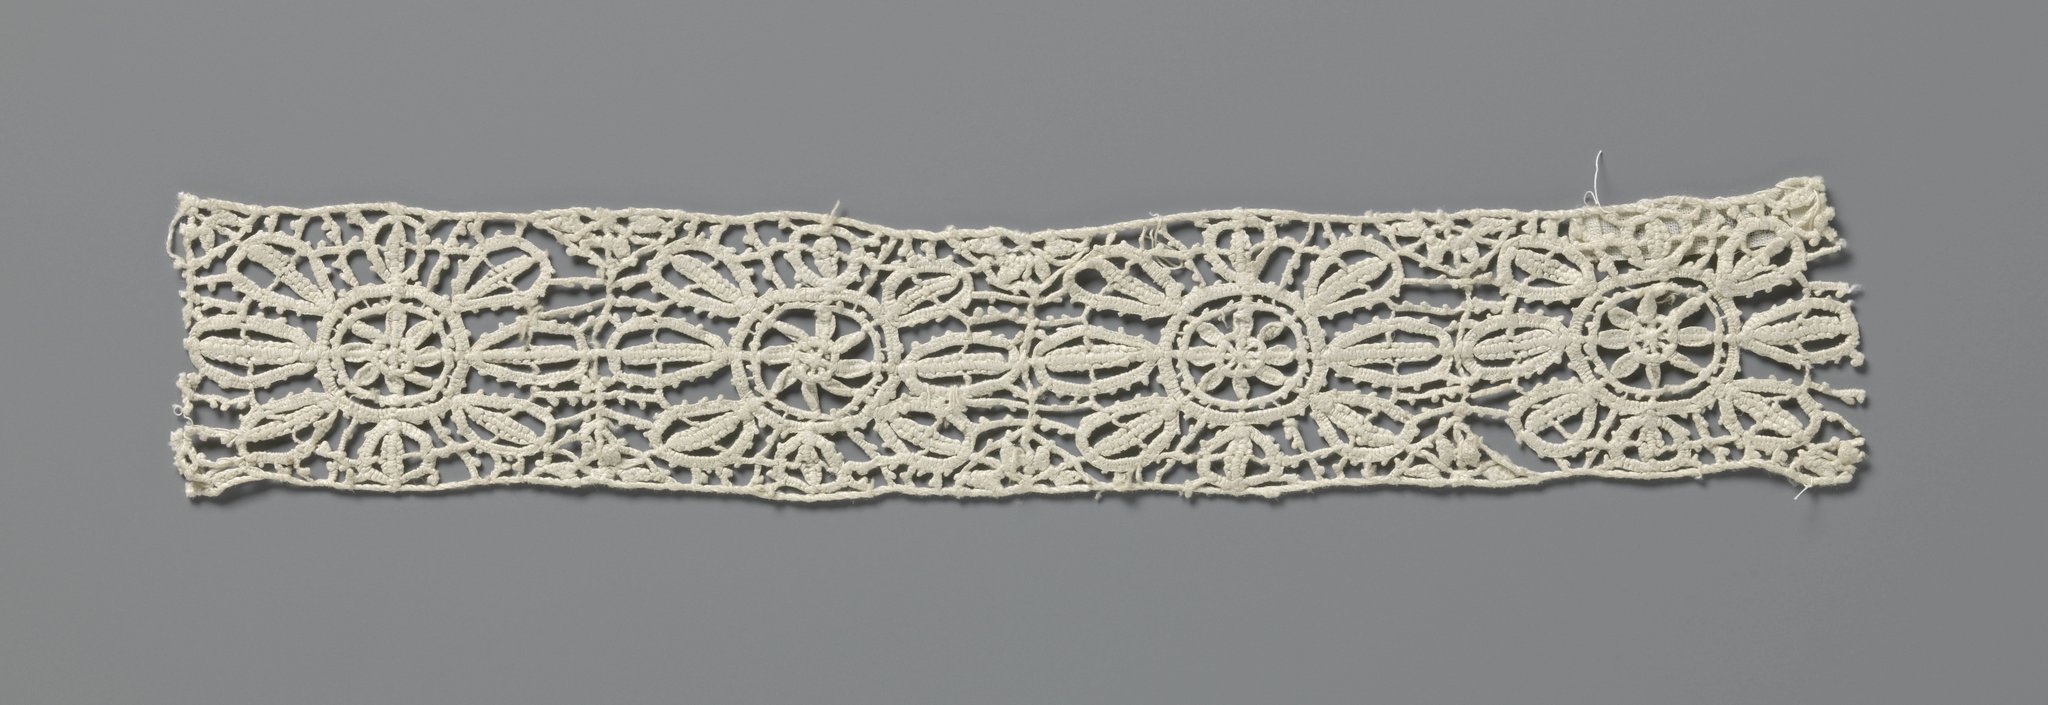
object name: strip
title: Strook naaldkant met dubbele rozetbloem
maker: Anonymous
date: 1500-1599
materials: linen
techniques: needle lace, reticella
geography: italy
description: Strook naturelkleurig naaldkant, reticella. Een zich herhalend patroon van één rozetbloem met acht bloemblaadjes, met in het centrum een rozetbloempje met evenveel bloemblaadjes. Het patroon, dus elke rozetbloem, beslaat de volledige breedte van de strook. Boven- en onderzijde zijn afgewerkt met een rechte rand.